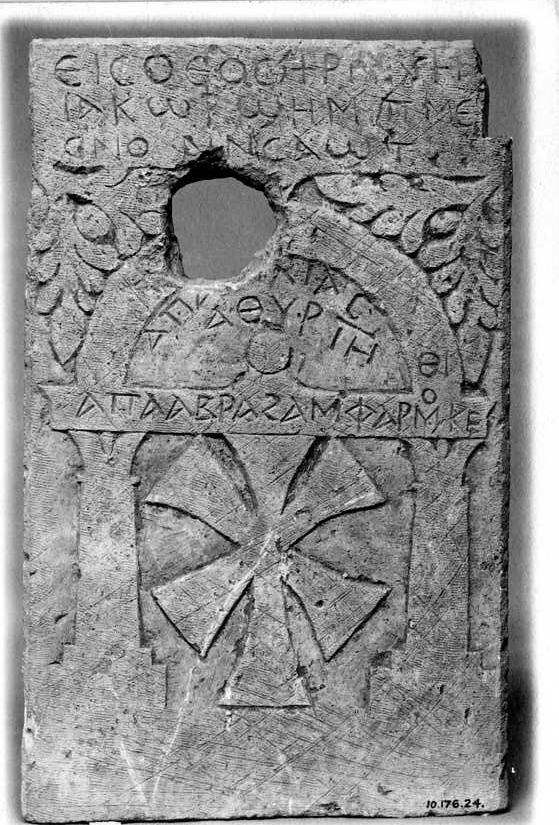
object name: stele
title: Inscribed Stele with a Cross at Center of Architectural Frame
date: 501-700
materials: limestone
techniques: carving, relief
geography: egypt